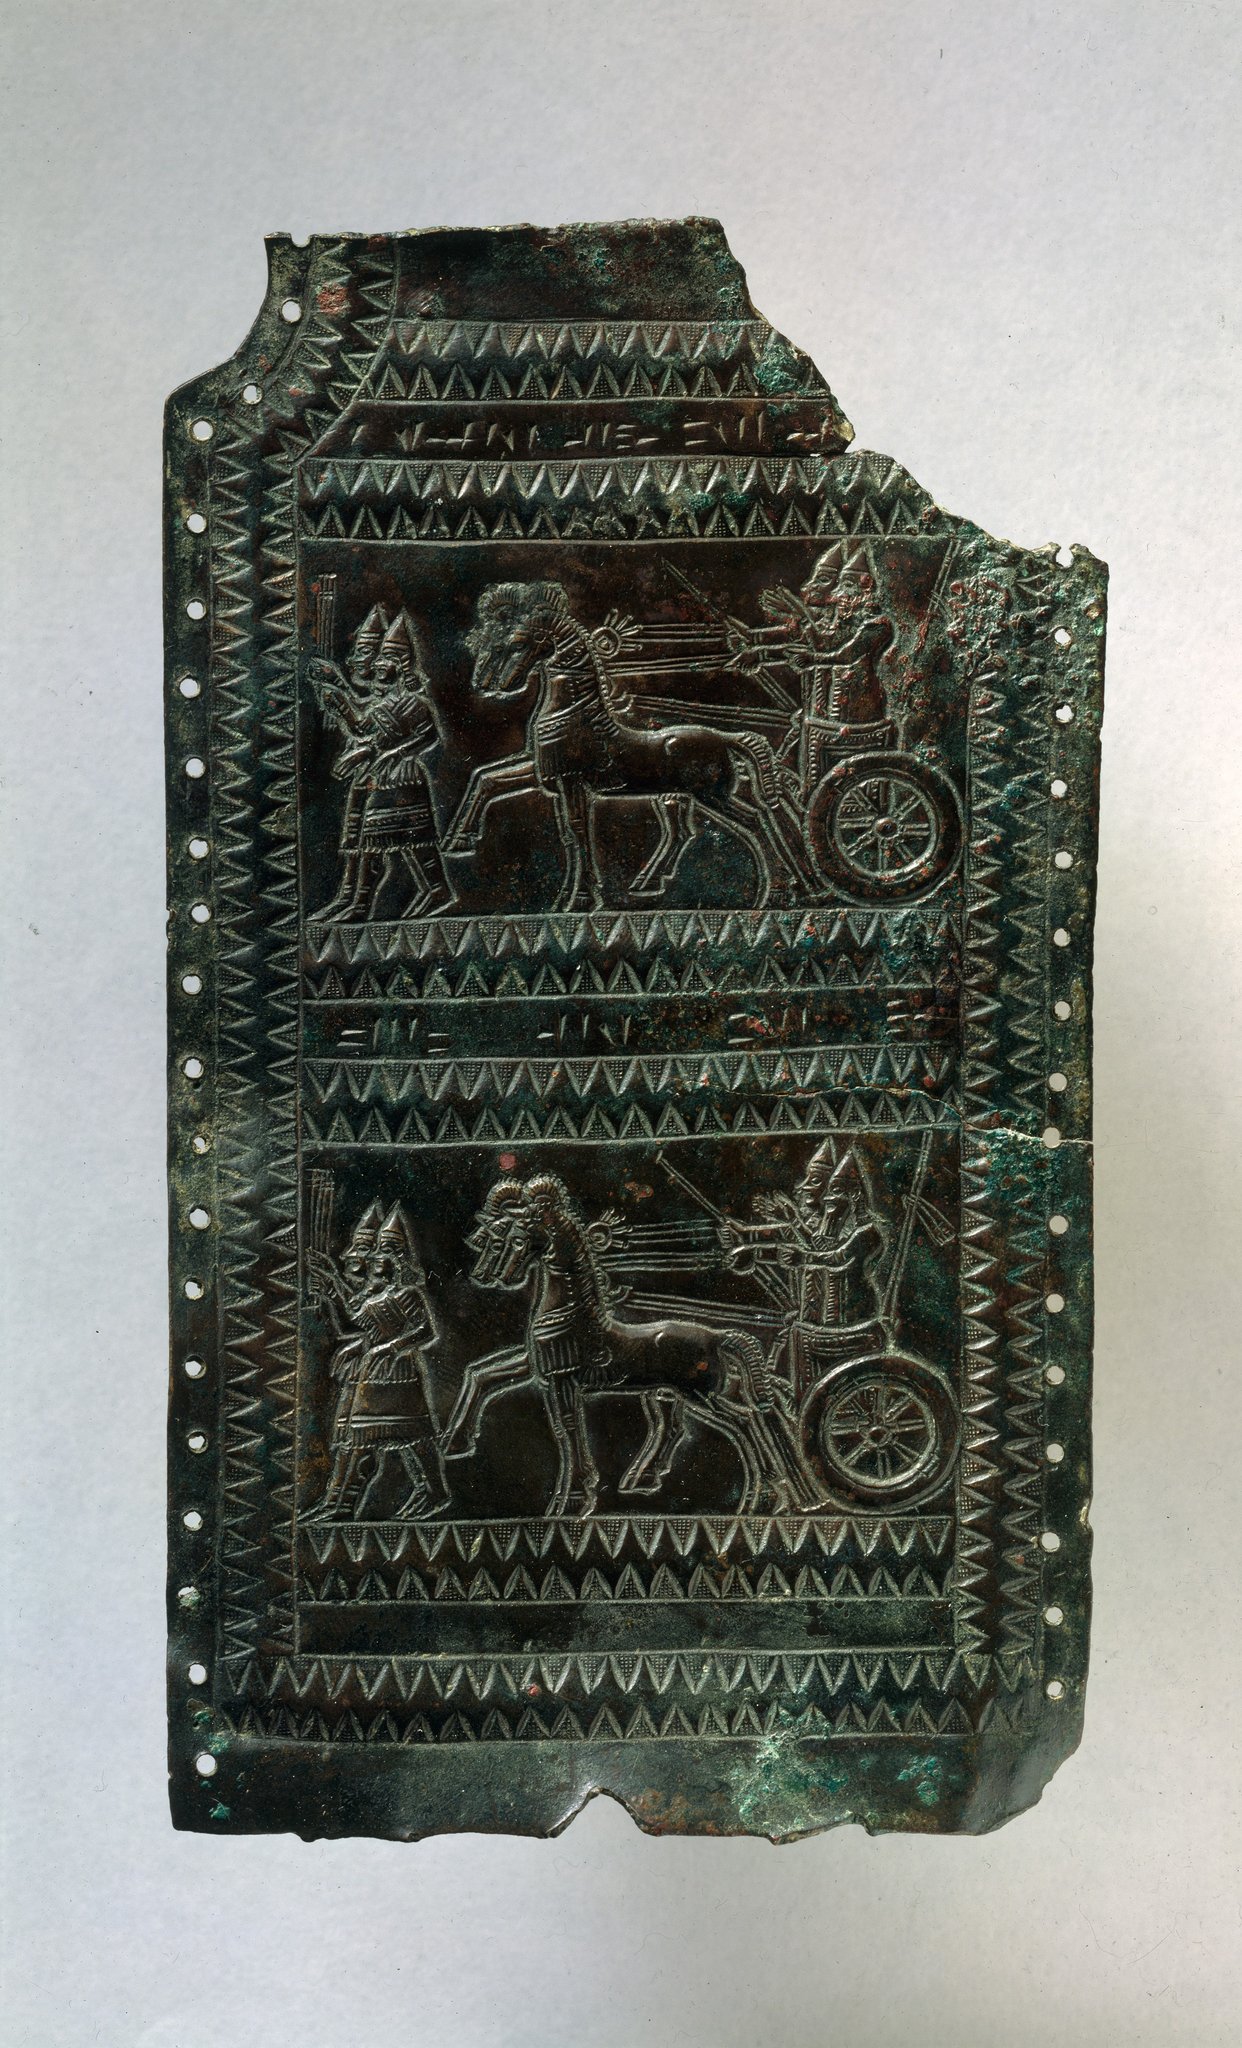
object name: relief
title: Plaque fragment with chariot scenes inscribed with the Urartian royal name Argishti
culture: urartian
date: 713-679 BCE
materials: bronze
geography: urartu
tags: men,horses,chariots